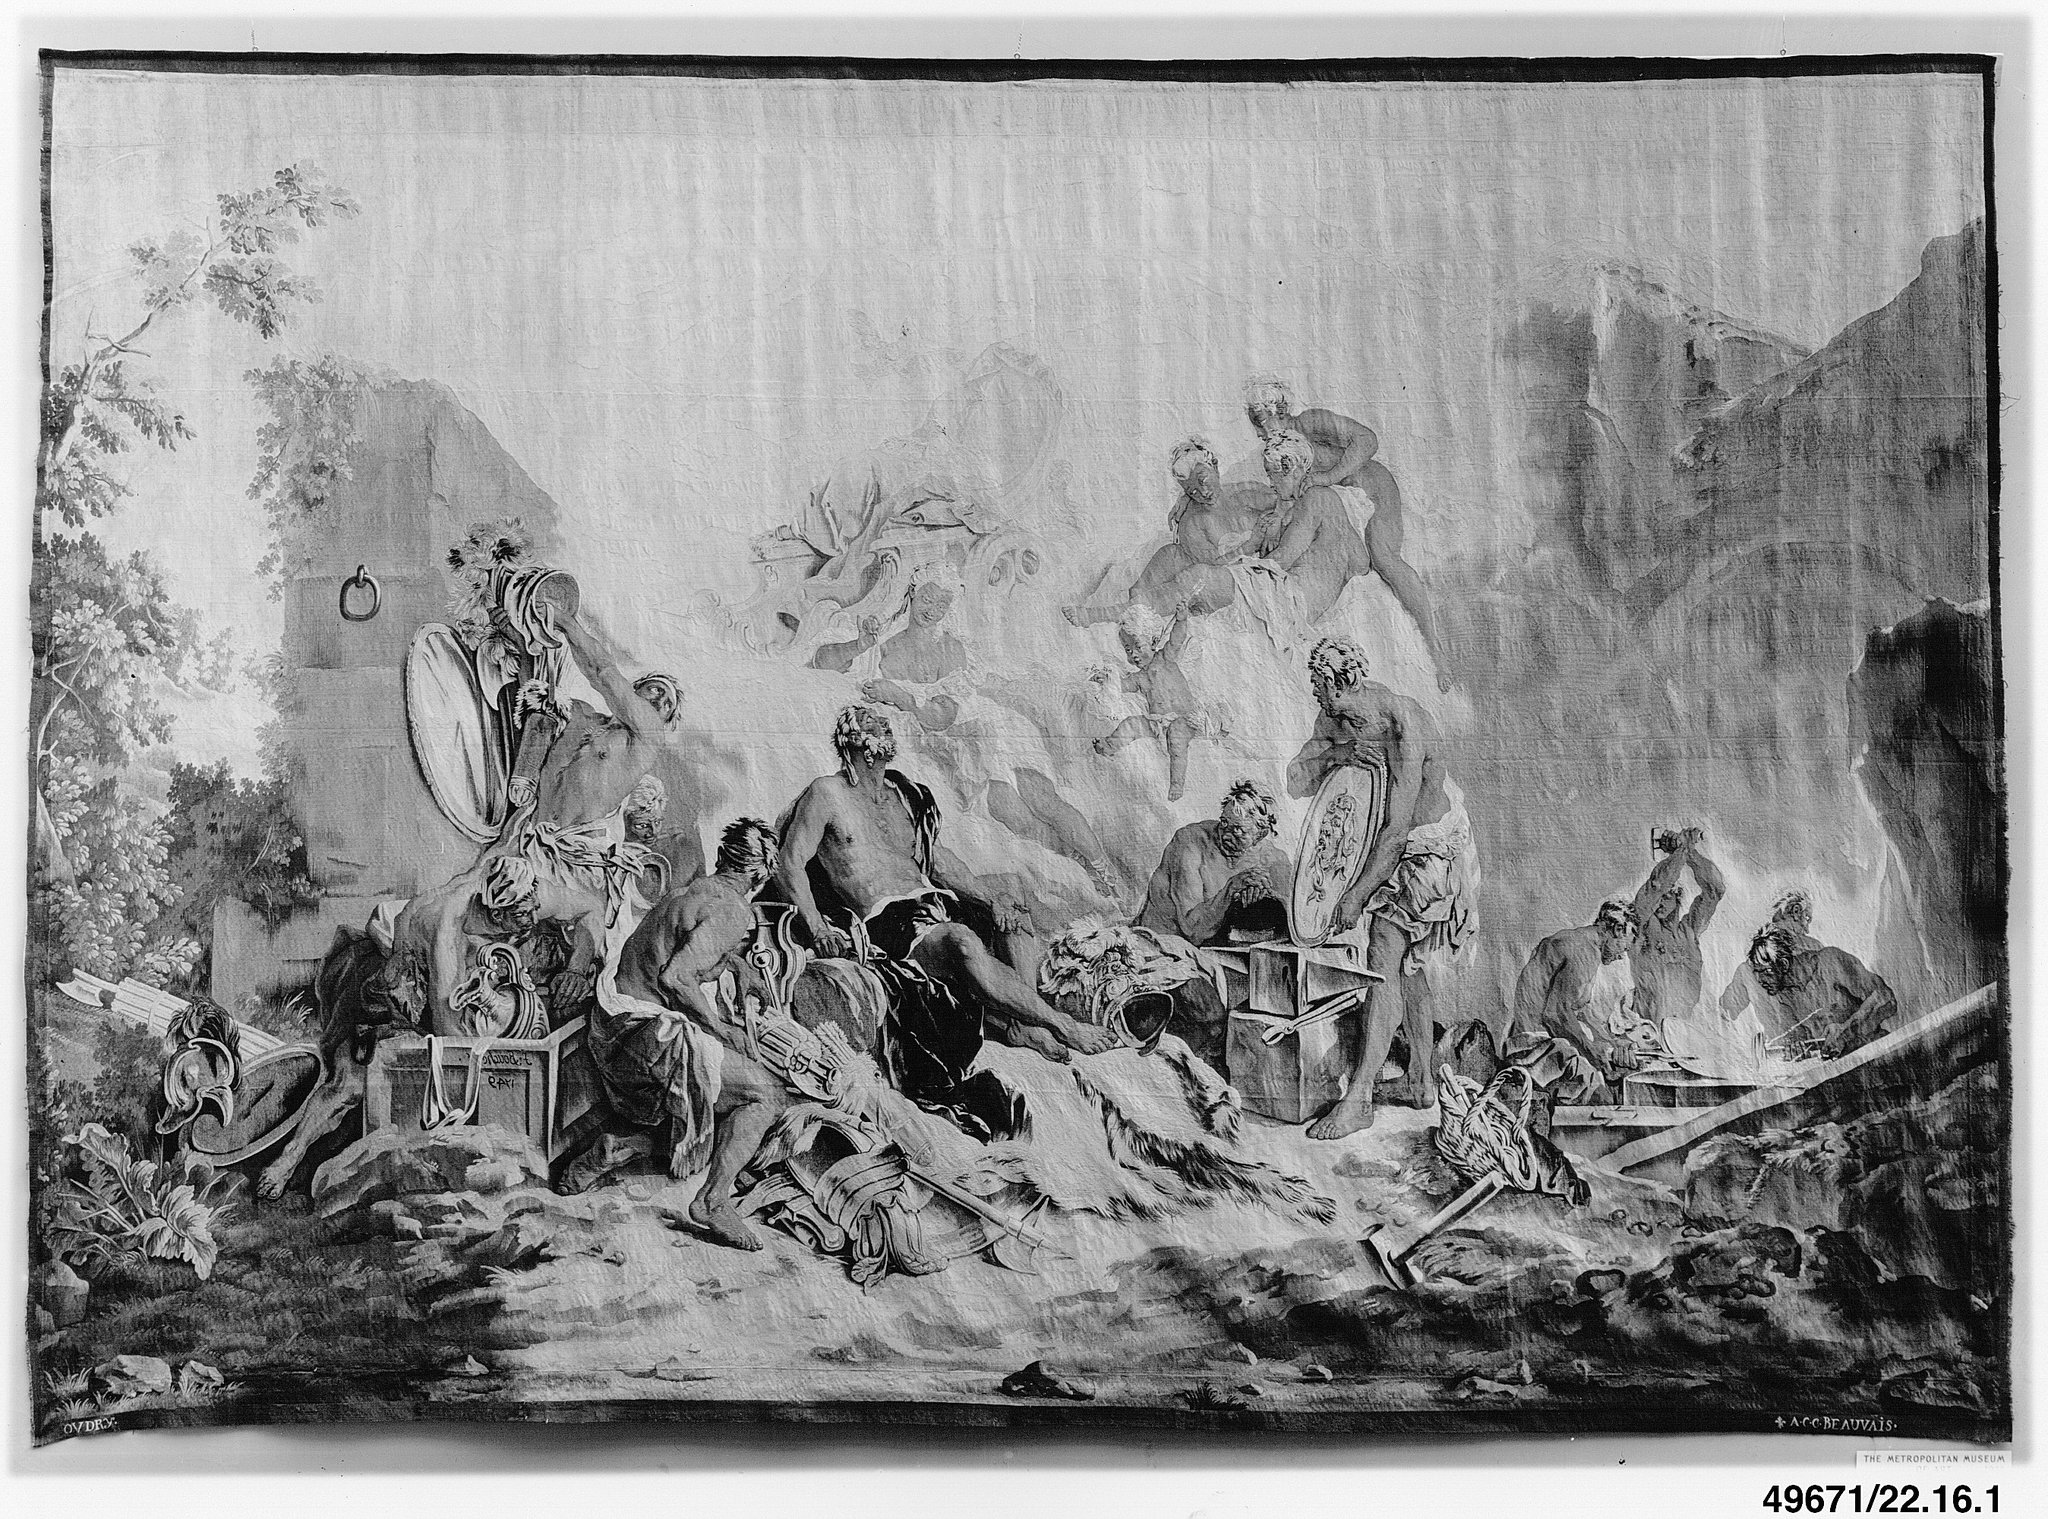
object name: tapestry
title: Vulcan Presenting Arms for Aeneas to Venus from a set of The Loves of the Gods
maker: françois boucher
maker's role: artist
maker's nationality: french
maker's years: 1703-1770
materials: silk, wool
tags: aeneas,venus,vulcan,mountains,trees